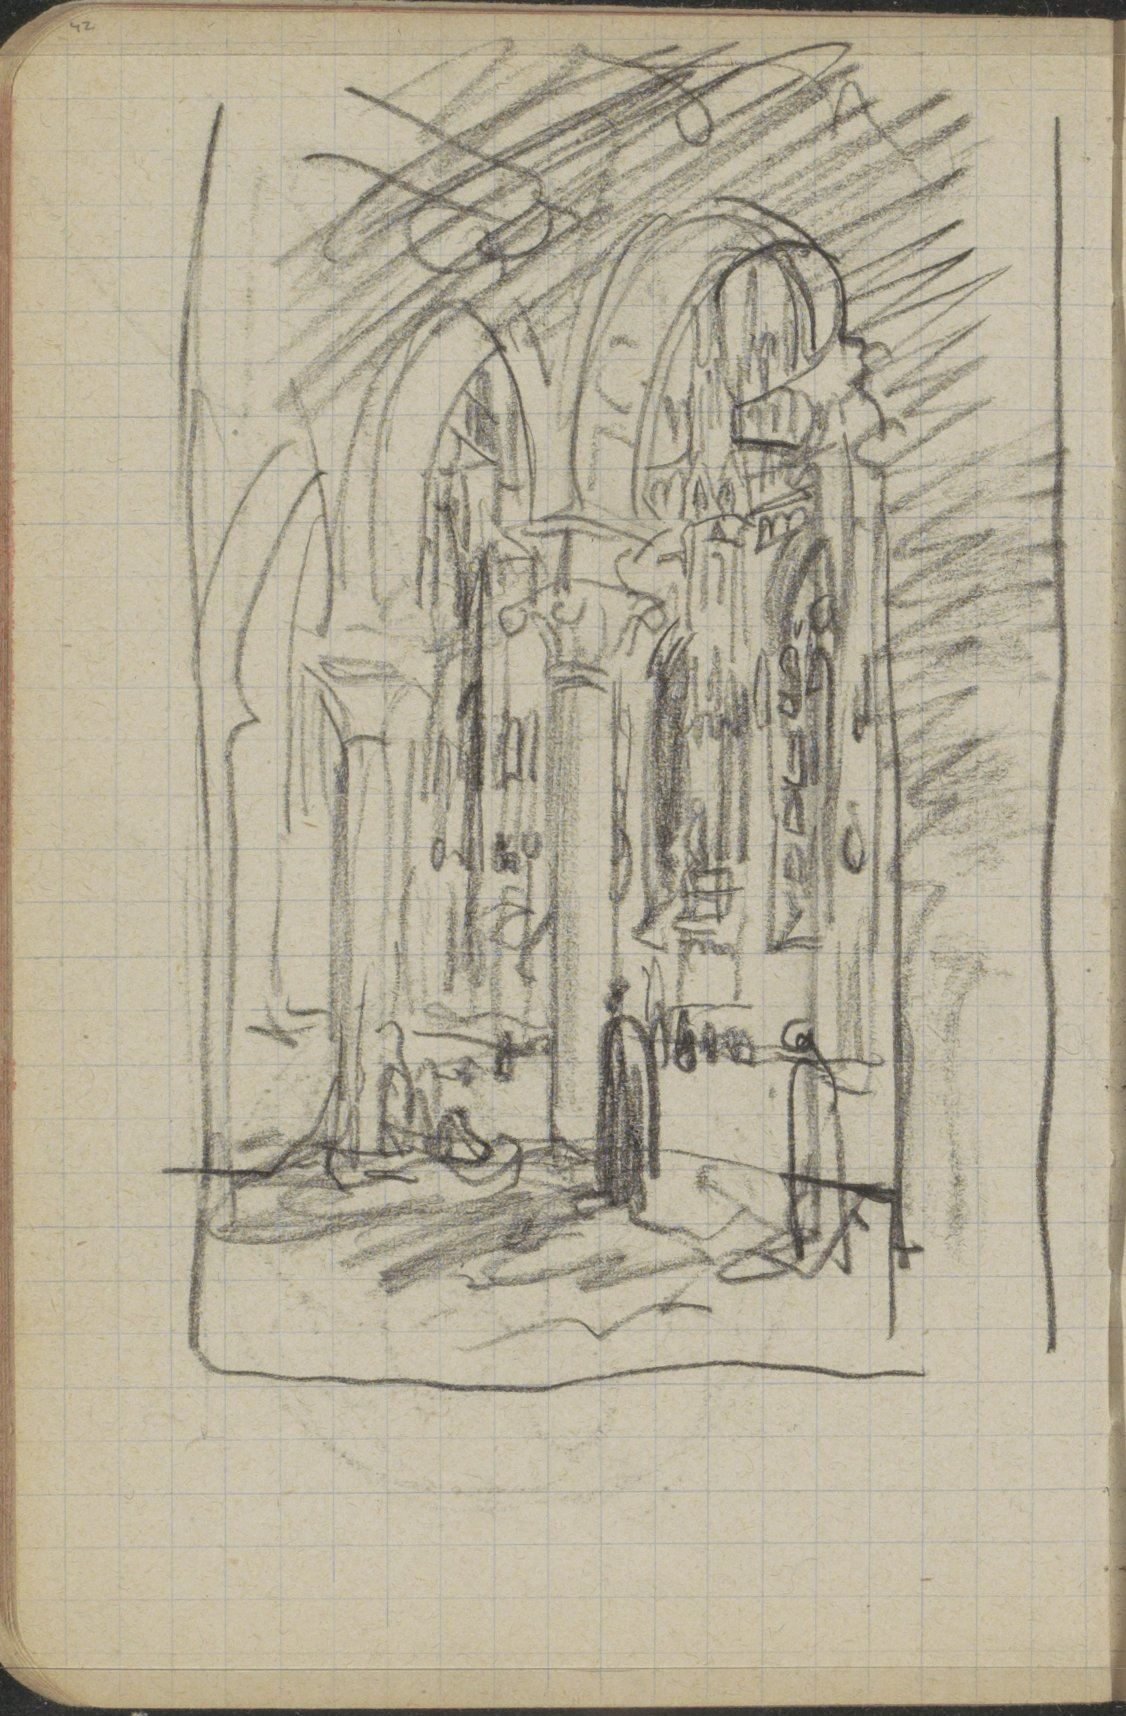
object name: sketchbook leaf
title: Gezicht vanuit een loggia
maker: marius bauer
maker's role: draughtsman, print maker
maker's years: 1867-1932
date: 1895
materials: chalk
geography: venice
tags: colonnade, architecture, loggia, verandah, porch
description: Mogelijk de loggia van de Basiliek van San Marco. Pagina 42 uit een schetsboek met 28 bladen.